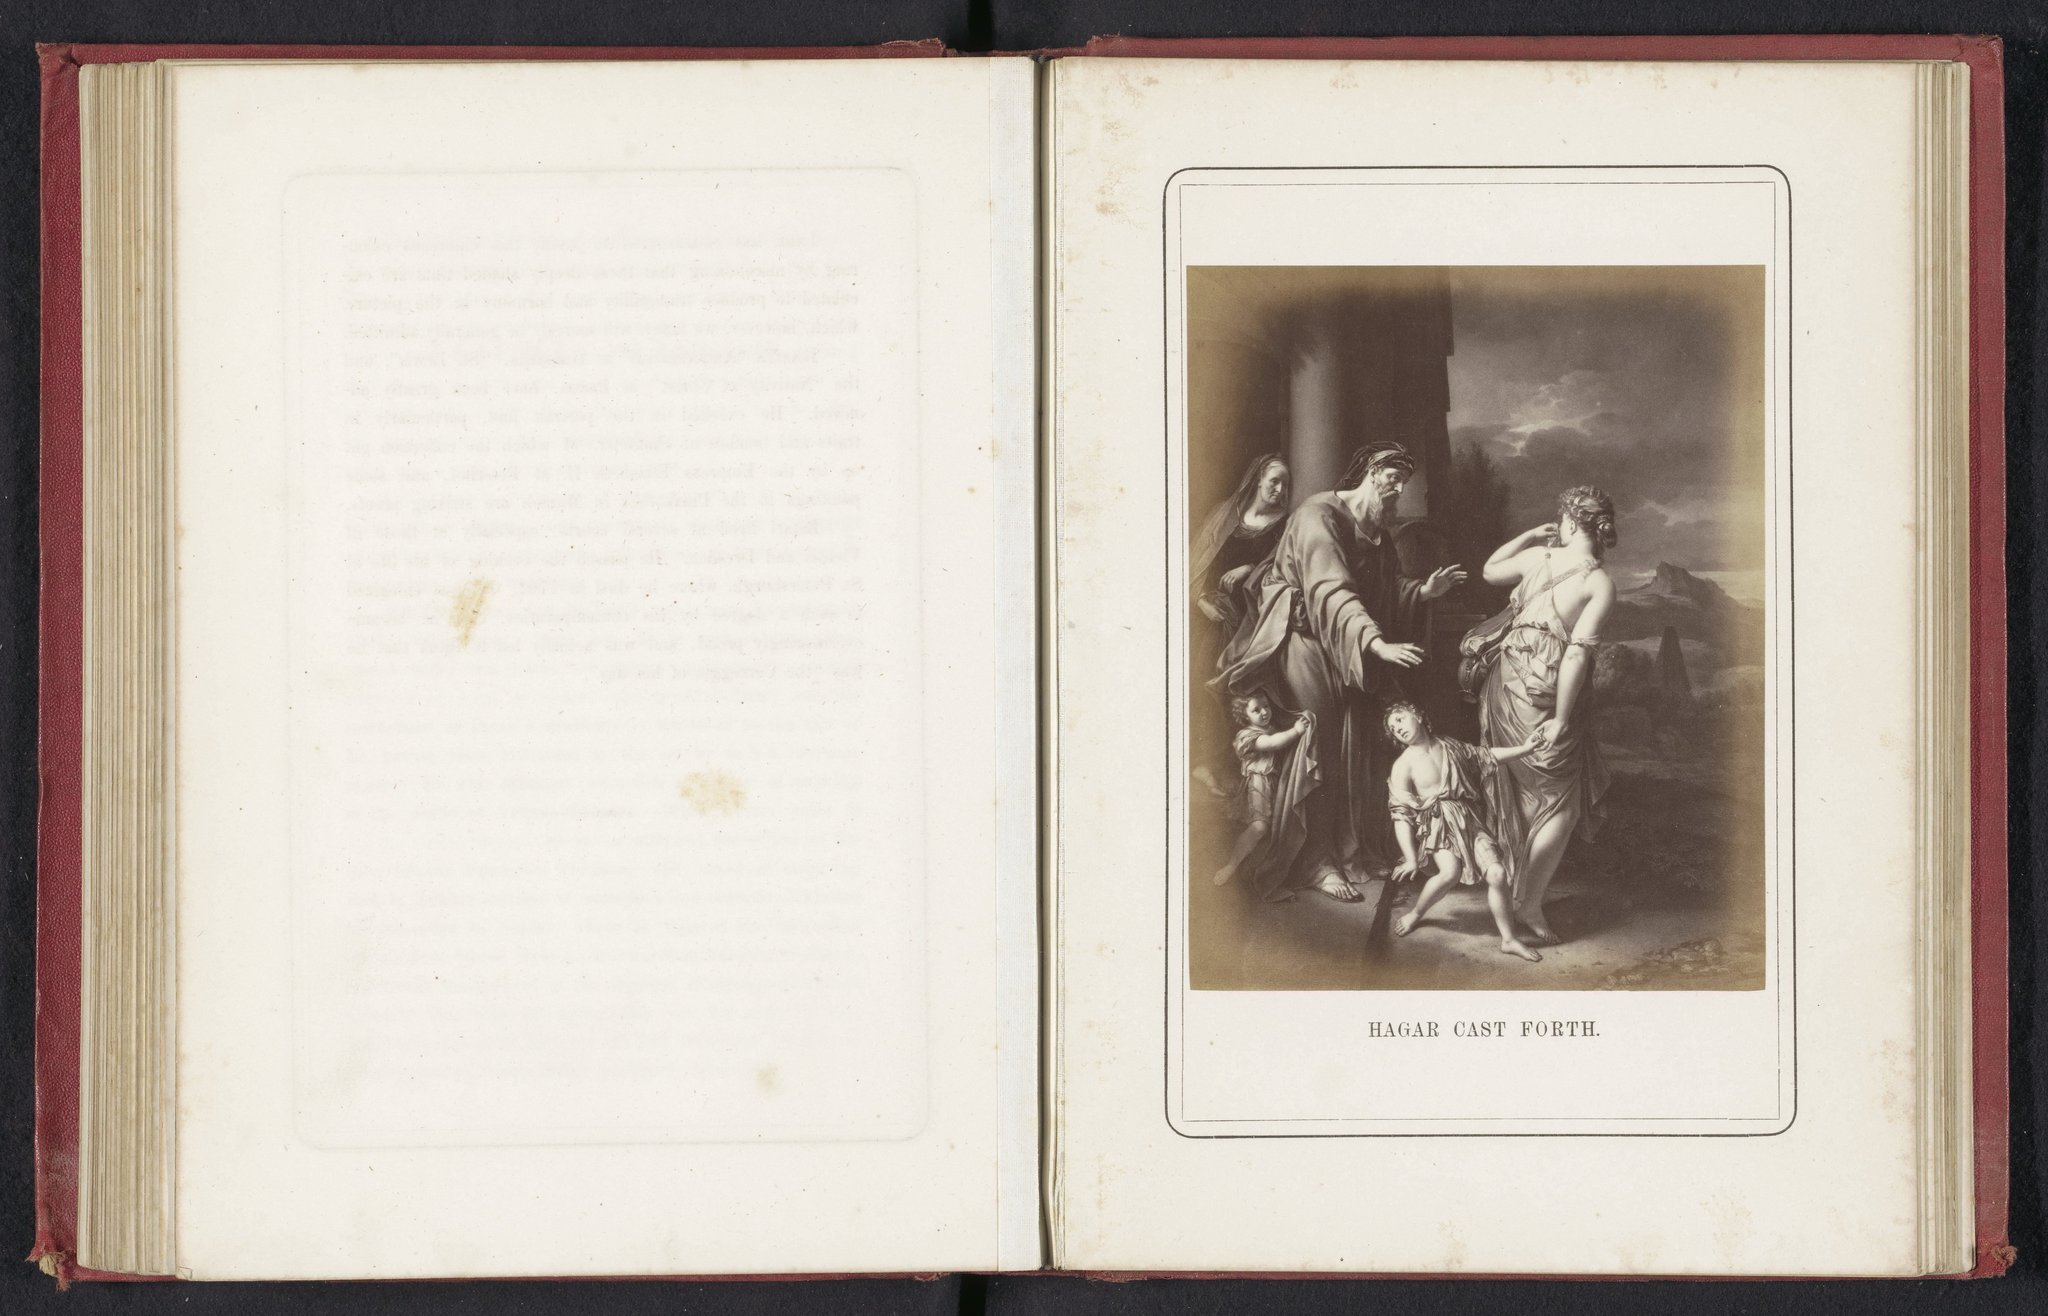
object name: page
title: Fotoreproductie van een schilderij van de uitwijzing van Hagar en Ismaël door Adrian van der Werff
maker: hanns hanfstaengl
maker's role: print maker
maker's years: 1820-1885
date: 1854-1864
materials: photographic support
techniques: albumen print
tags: the banishment of hagar and ishmael (genesis 21:9-21), picture, painting